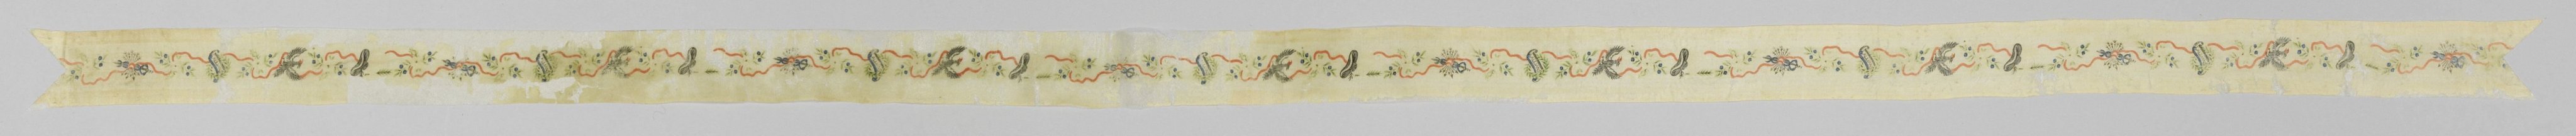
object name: menswear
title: Lint Allians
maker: Anonymous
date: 1894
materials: silk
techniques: printing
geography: western europe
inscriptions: : ‘Allians’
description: Zijden lint bestaande uit een brede witte baan met aan weerskanten een smallere verbleekte oranje. Op de witte is gedrukt in reperterend patroon een geslingerd rood lint, waarop een vrijheidshoed, een adelaar (?) een spreukband, dragende het woord 'Allians' en een bundel van zeven pijlen op een mercuriusstaf, alles afgewisseld door rozentakjes.